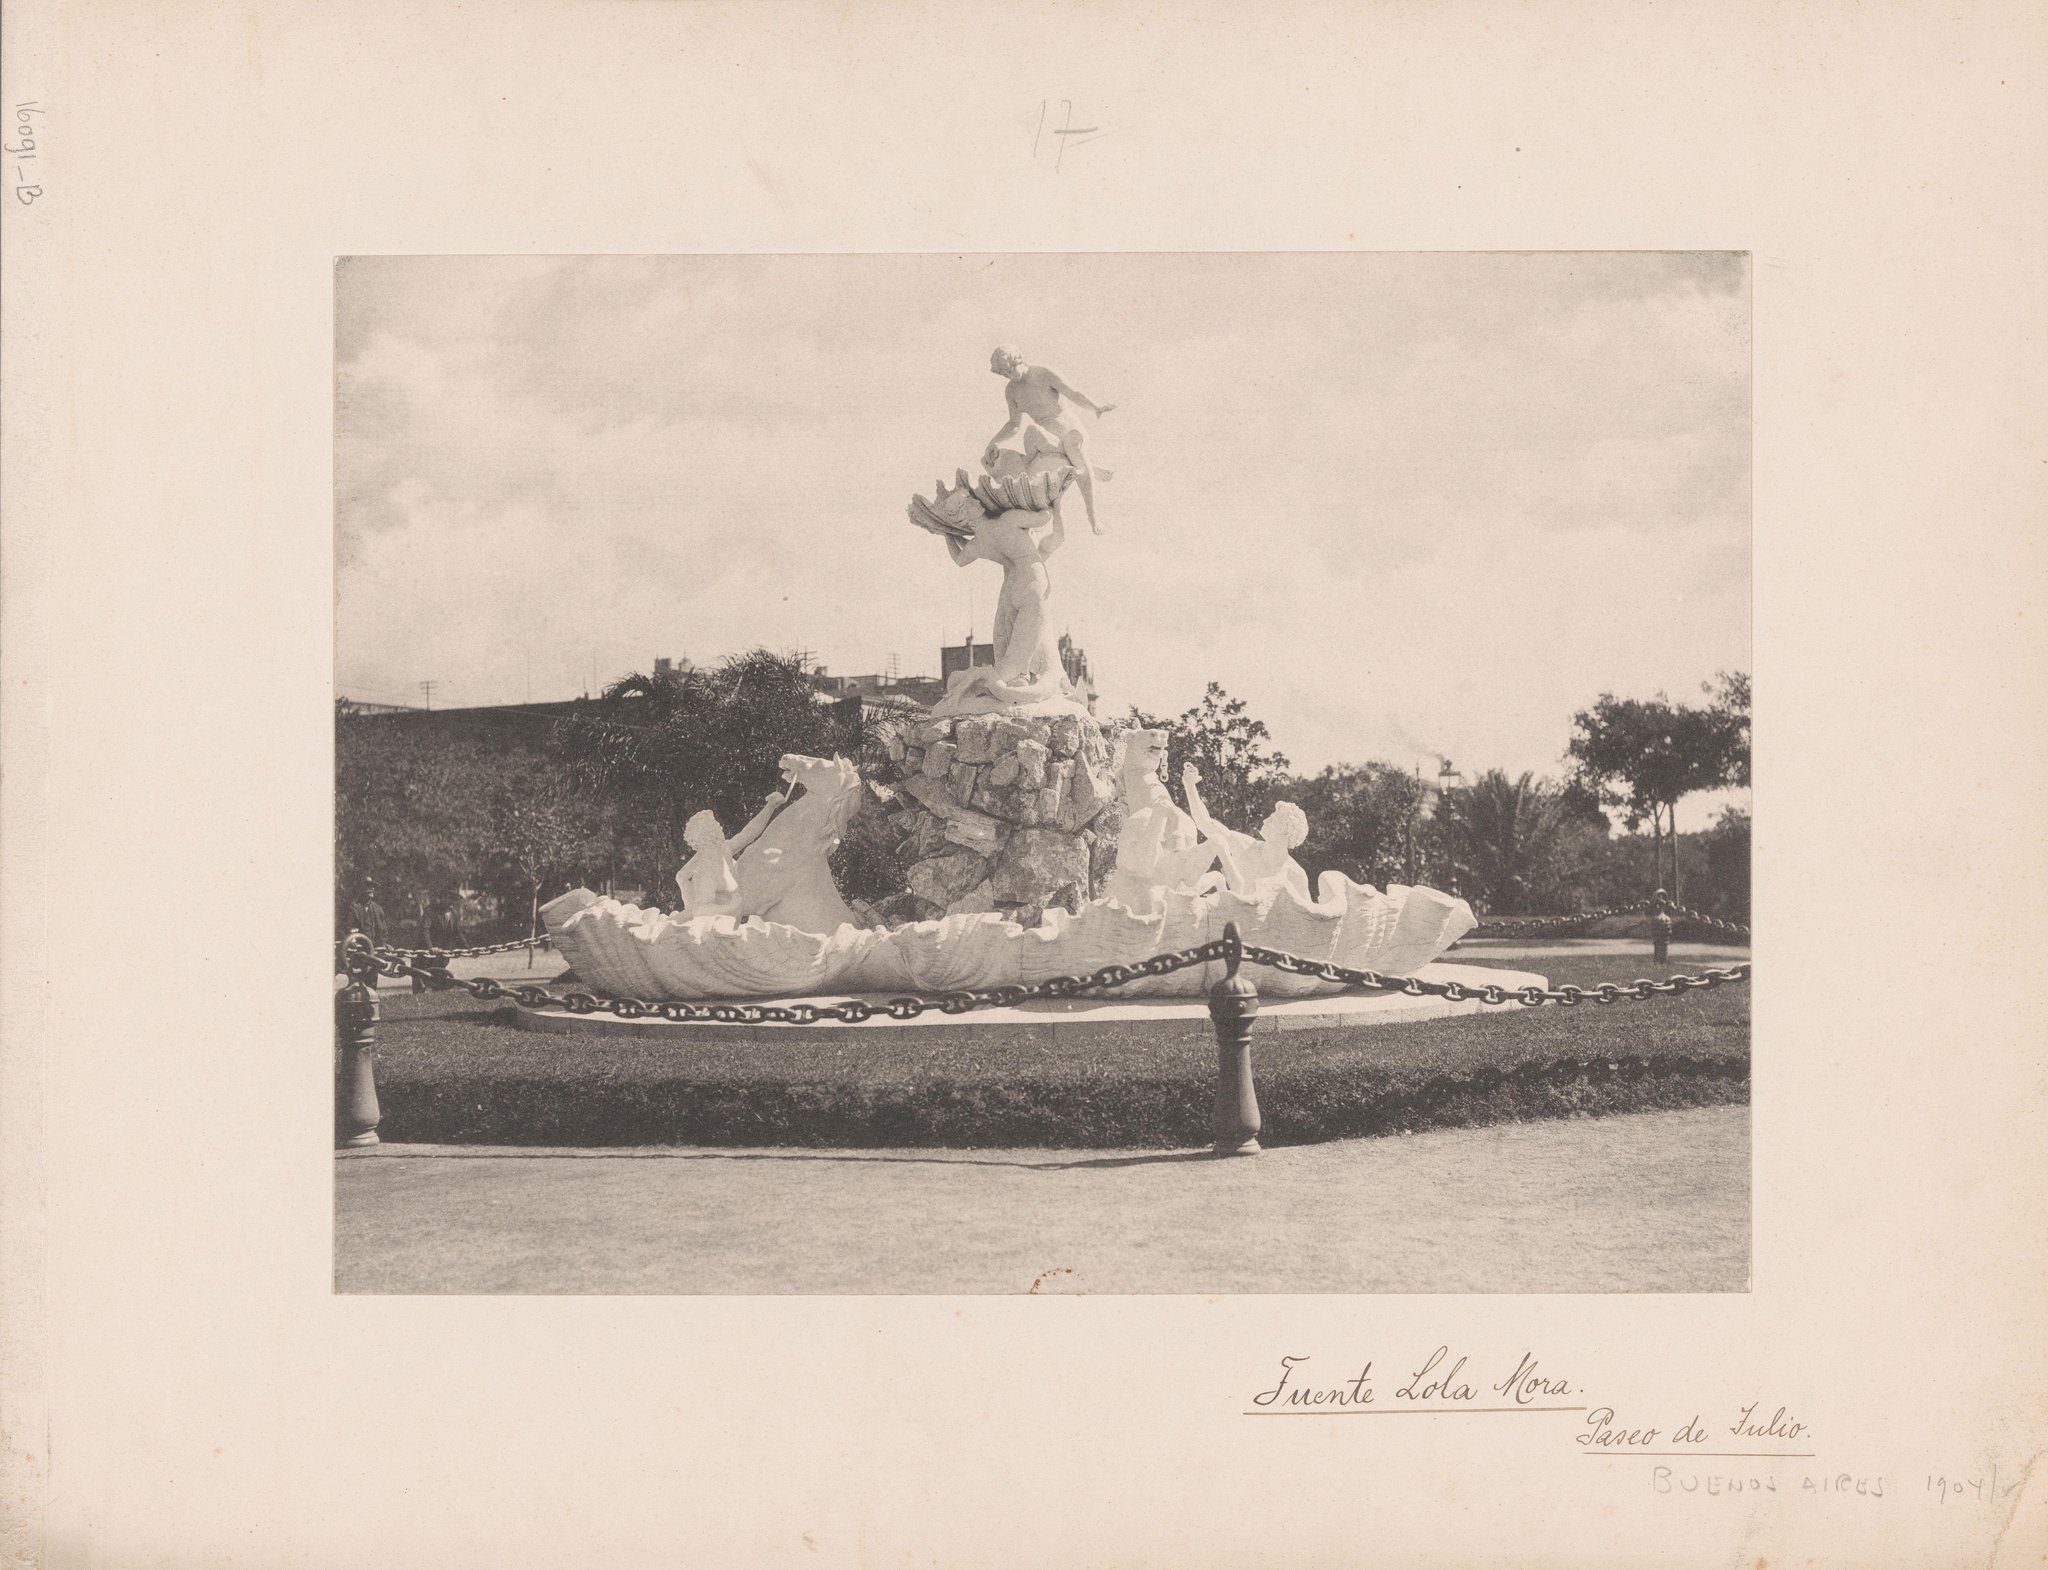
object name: photomechanical print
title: Nereïdenfontein in Buenos Aires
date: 1904-1905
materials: cardboard, paper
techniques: photograph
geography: buenos aires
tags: ornamental fountain